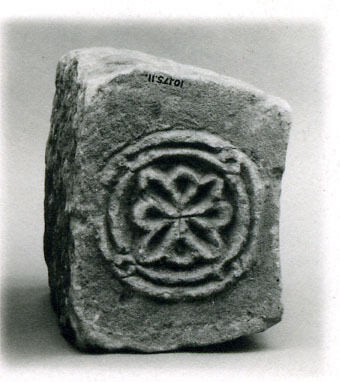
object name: fragment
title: Block from an Arch with a Rosette Medallion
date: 501-700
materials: stone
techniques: carving, relief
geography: egypt